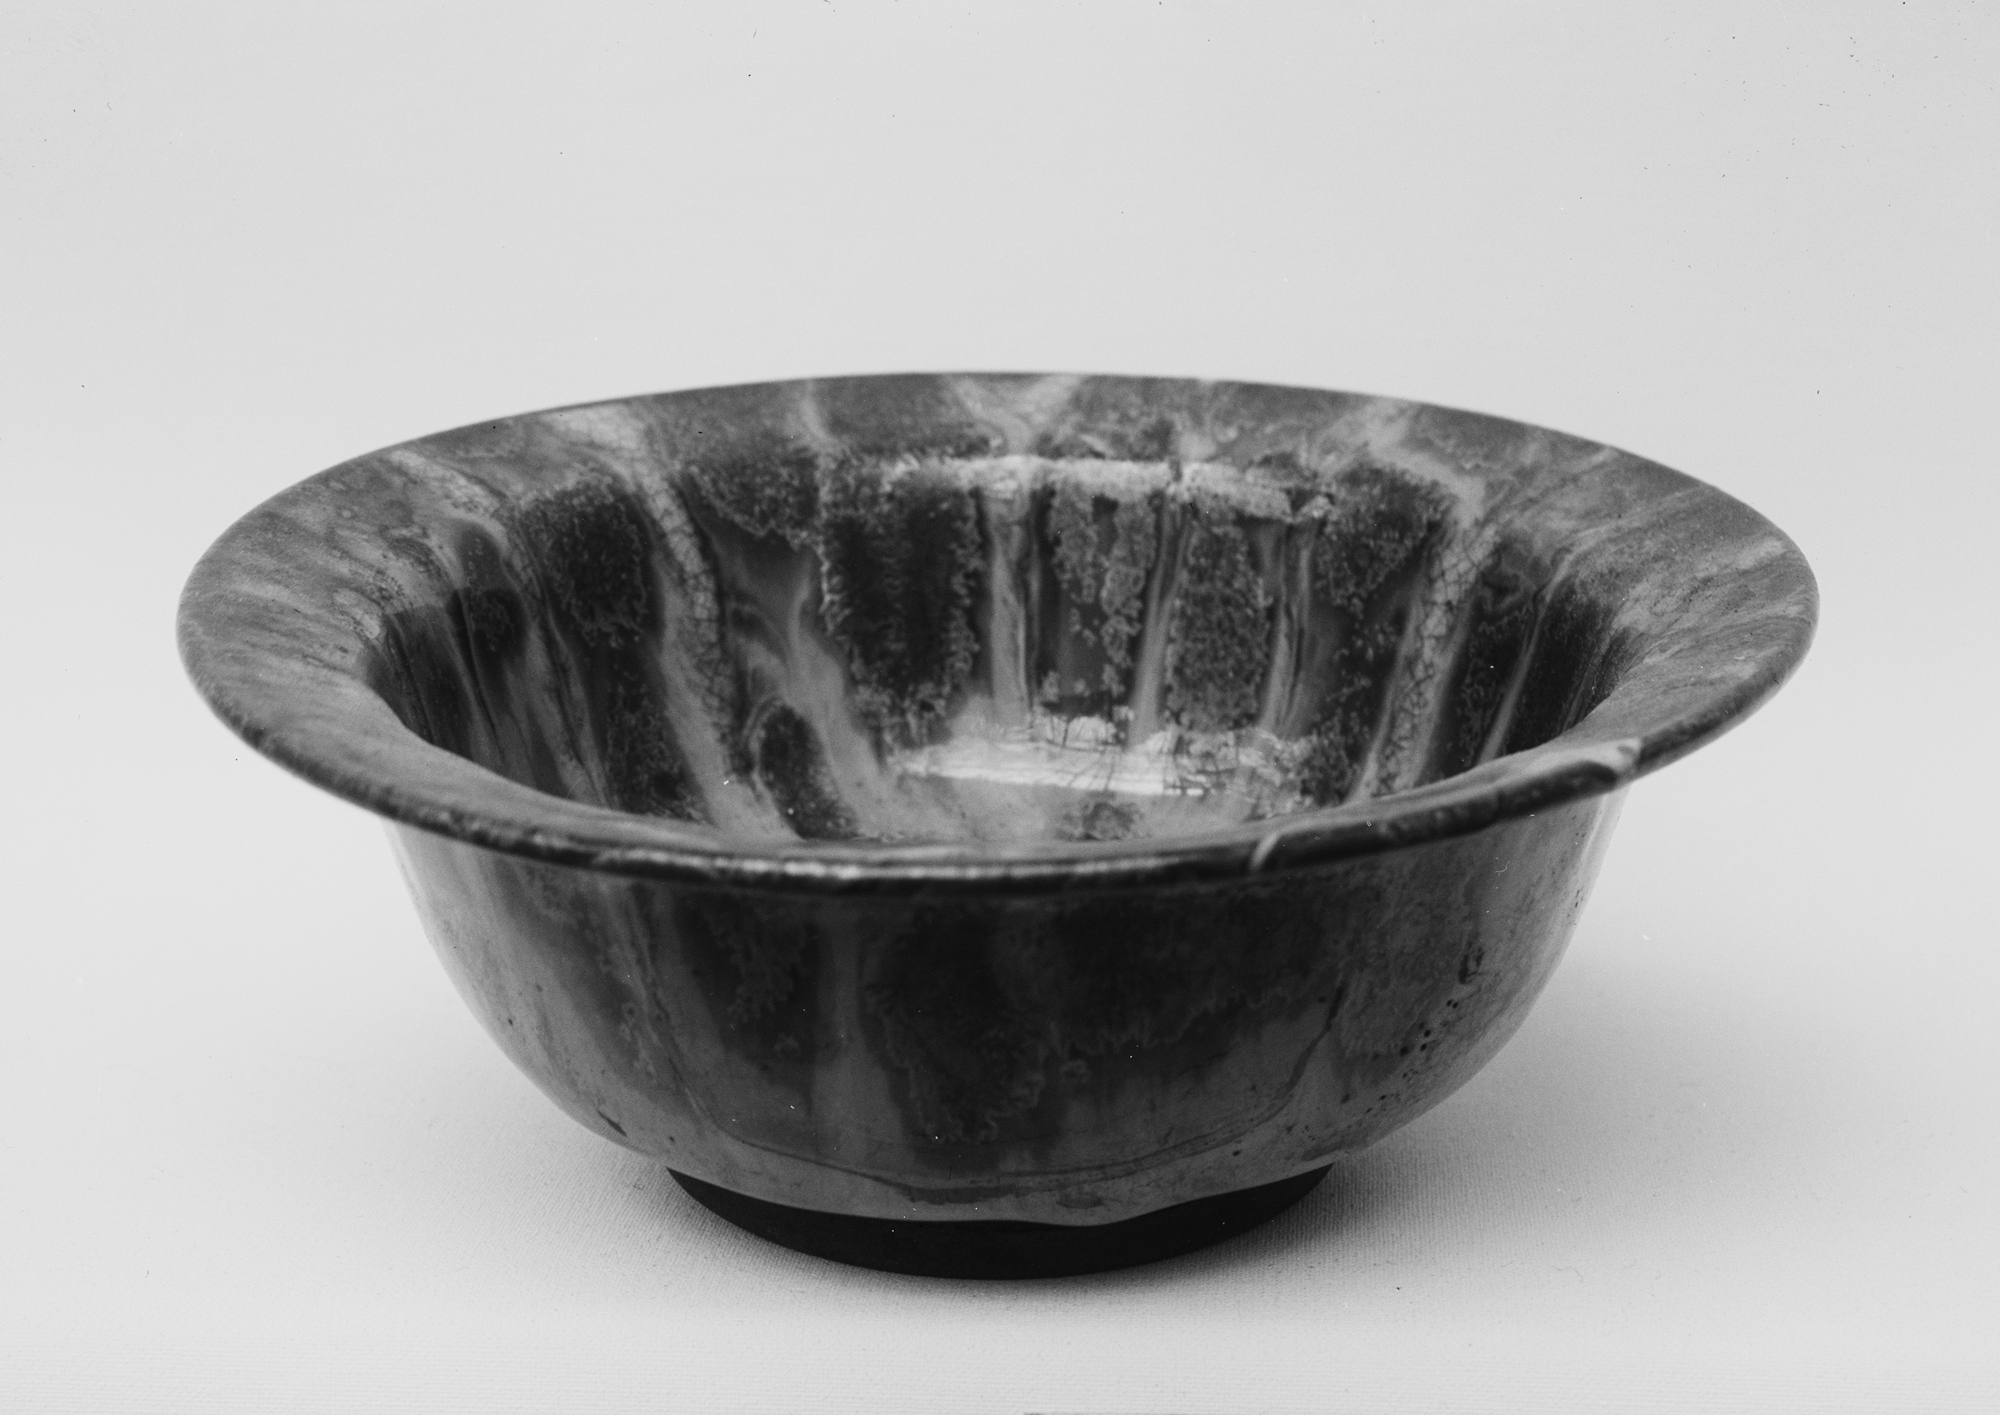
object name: bowl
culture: japanese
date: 1650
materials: clay, glaze